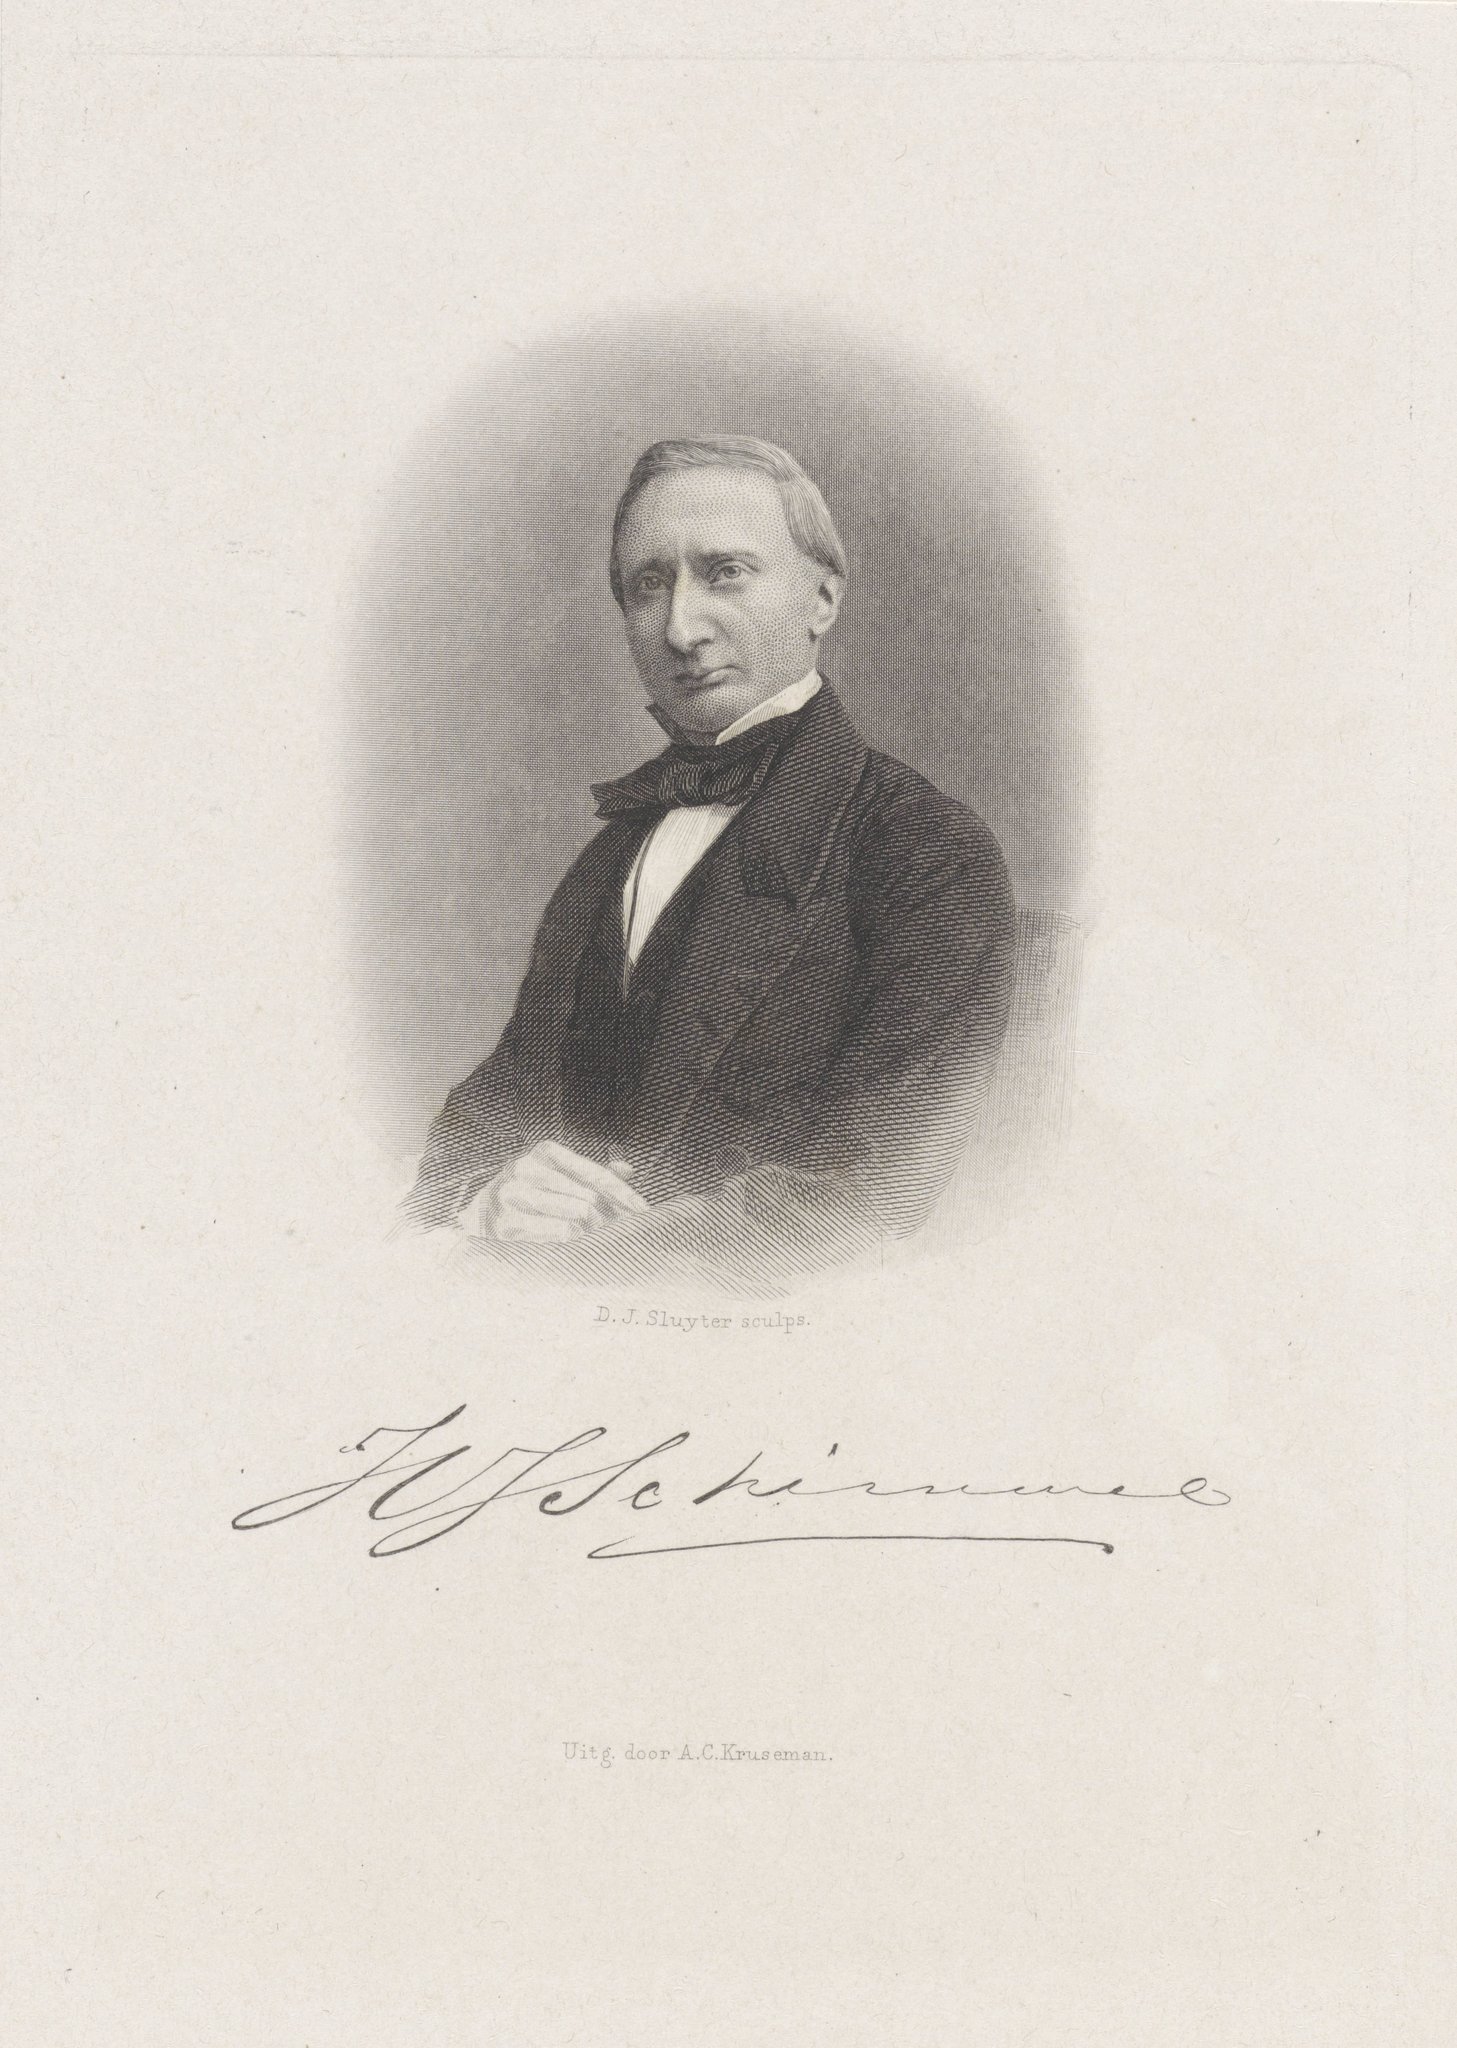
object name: print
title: Portret van Hendrik Jan Schimmel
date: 1850-1886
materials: paper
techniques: etching, engraving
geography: amsterdam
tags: hendrik jan schimmel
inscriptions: collector's mark: Lugt 2228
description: Portret van de dichter, roman- en toneelschrijver Hendrik Jan Schimmel. Onder het portret zijn handtekening.